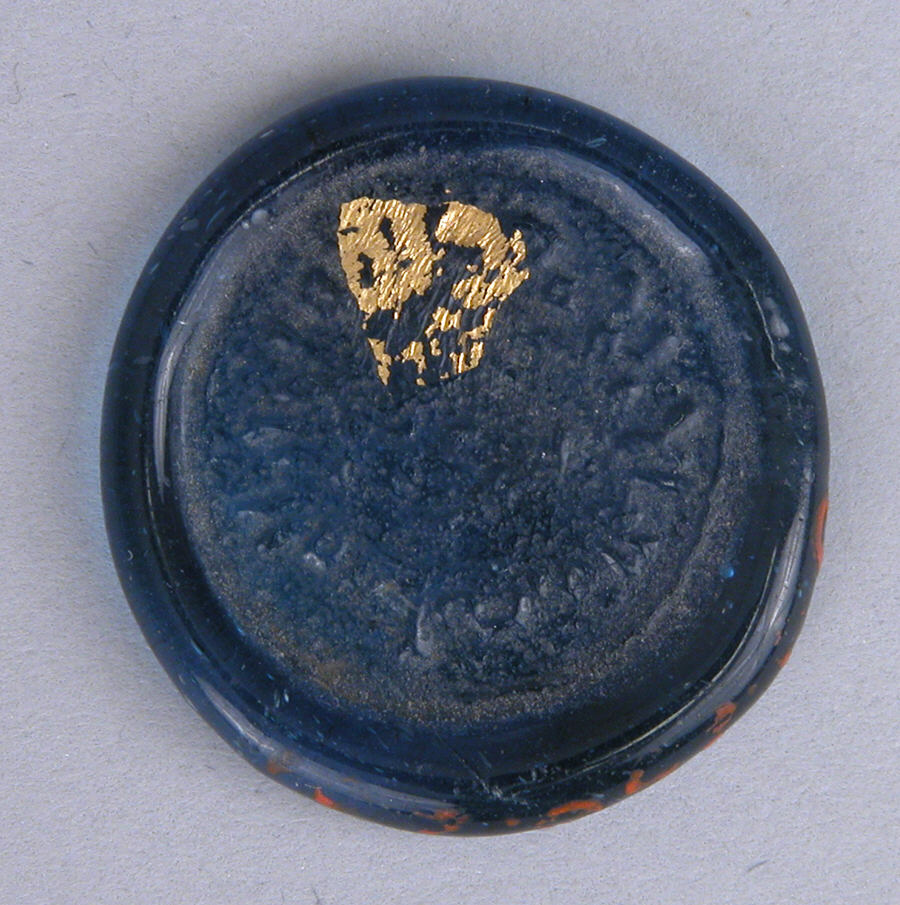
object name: coin weight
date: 1001-1100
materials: glass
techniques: pressed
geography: egypt